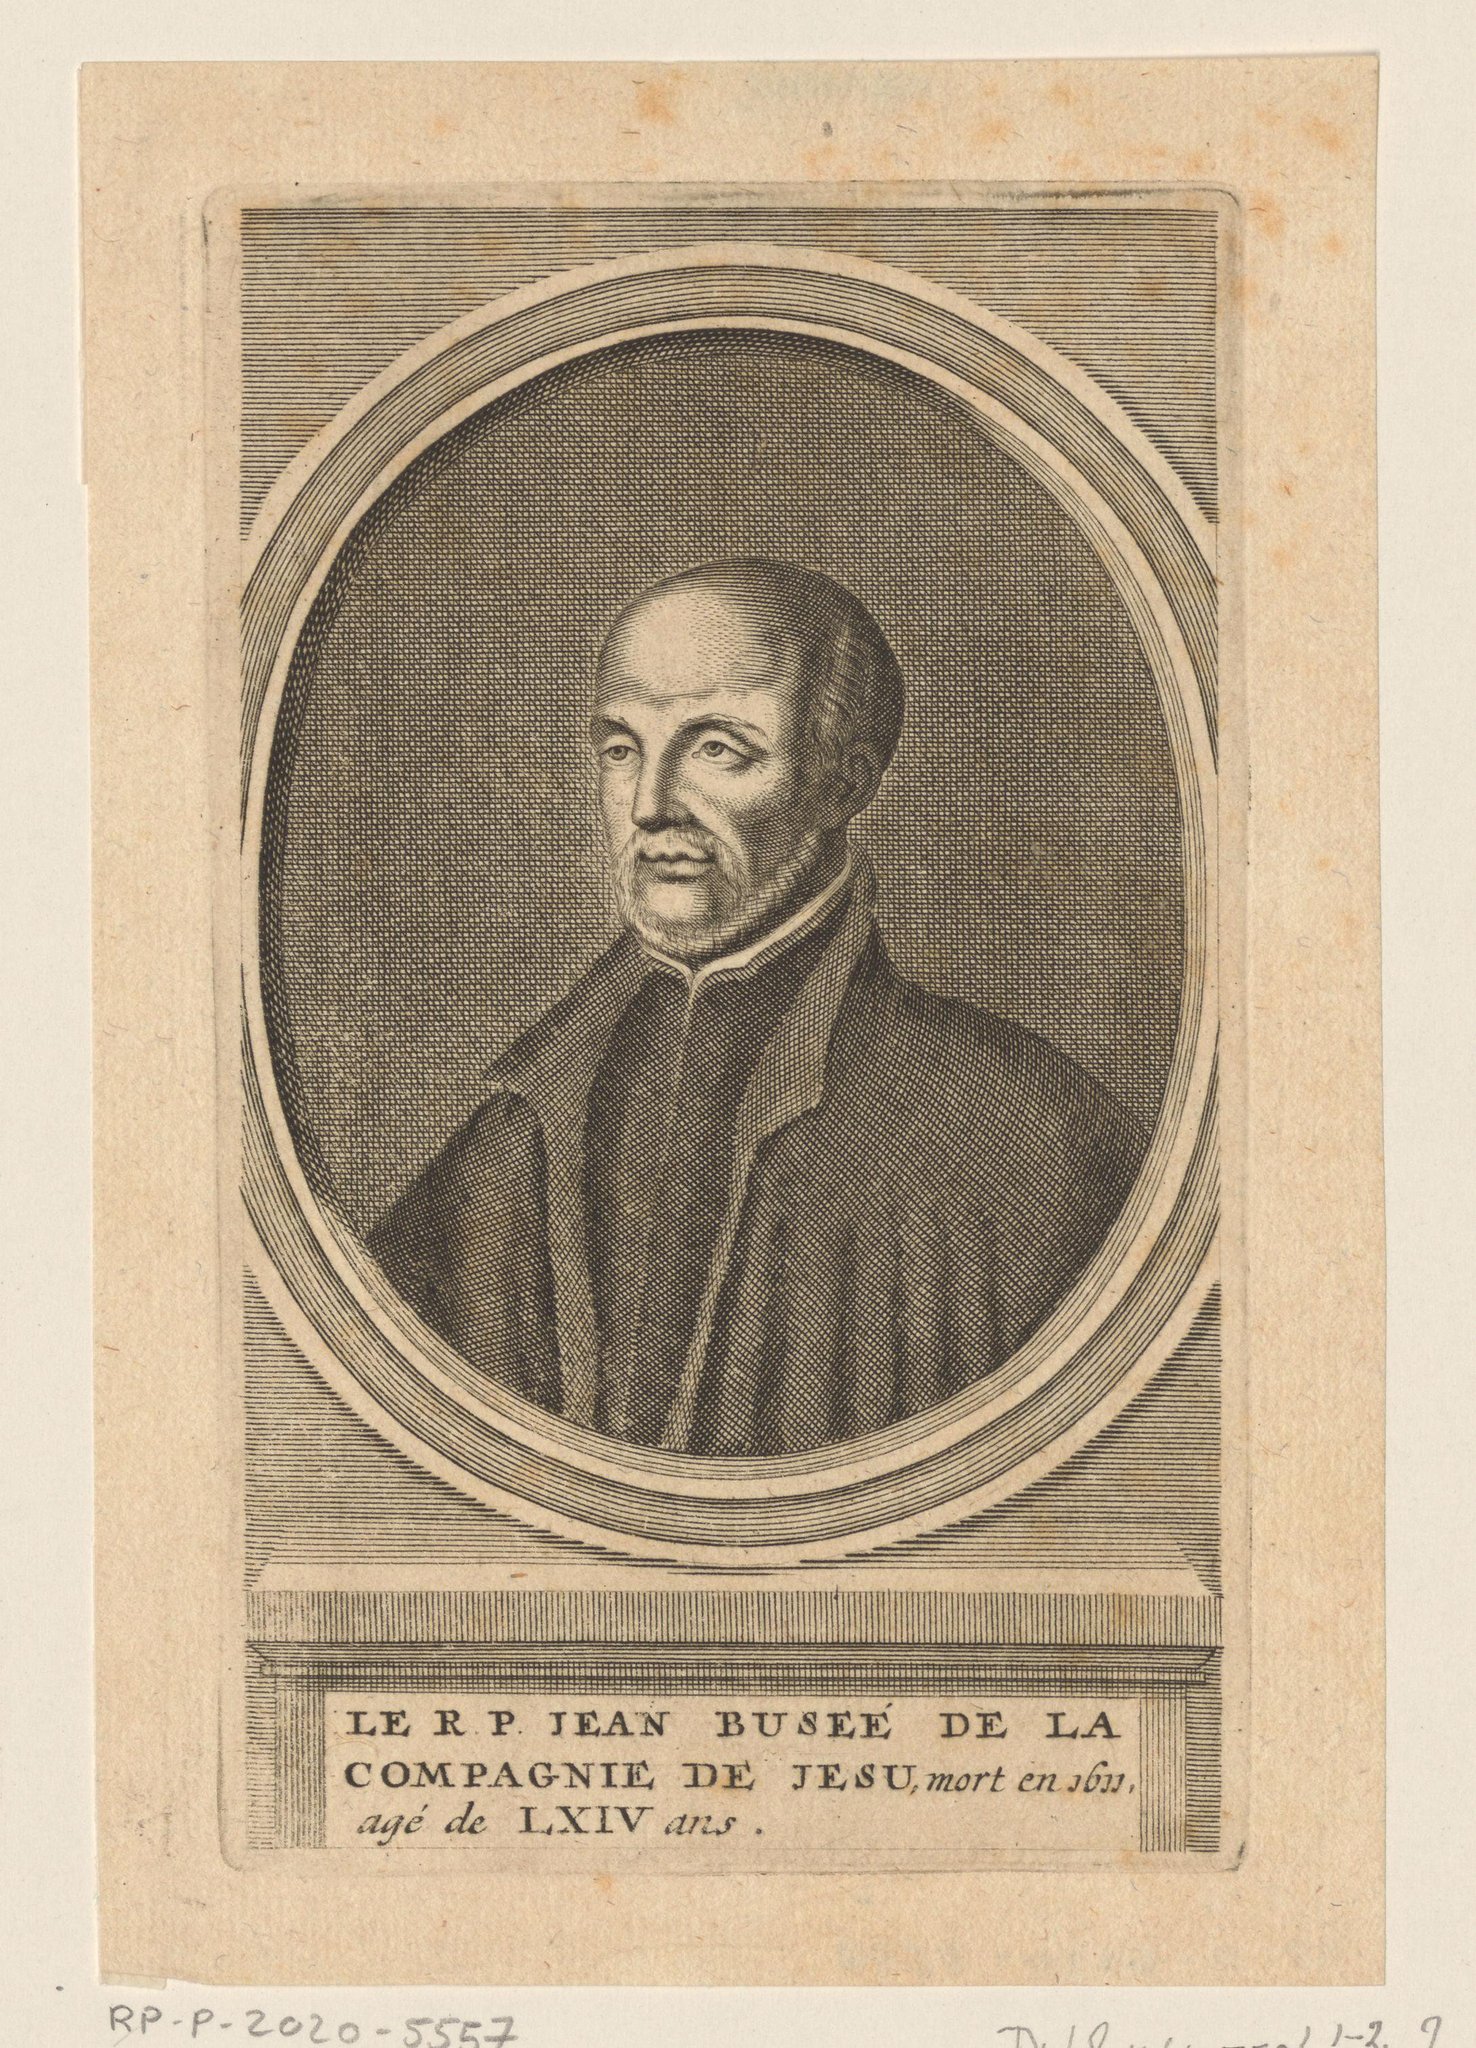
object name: print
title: Portret van Joannes Busaeus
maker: Anonymous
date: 1700-1724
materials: paper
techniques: engraving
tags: theologian, historical persons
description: Prent mogelijk uit: Busaeus, Joannes. Méditations pour l'avent, le carême, les quatre-tems, les dimanches, les fetes, et les principales feries de toute l'année (...). Brussel: François Foppens, 1707. Prent mogelijk ook gebruikt in andere edities of publicaties.